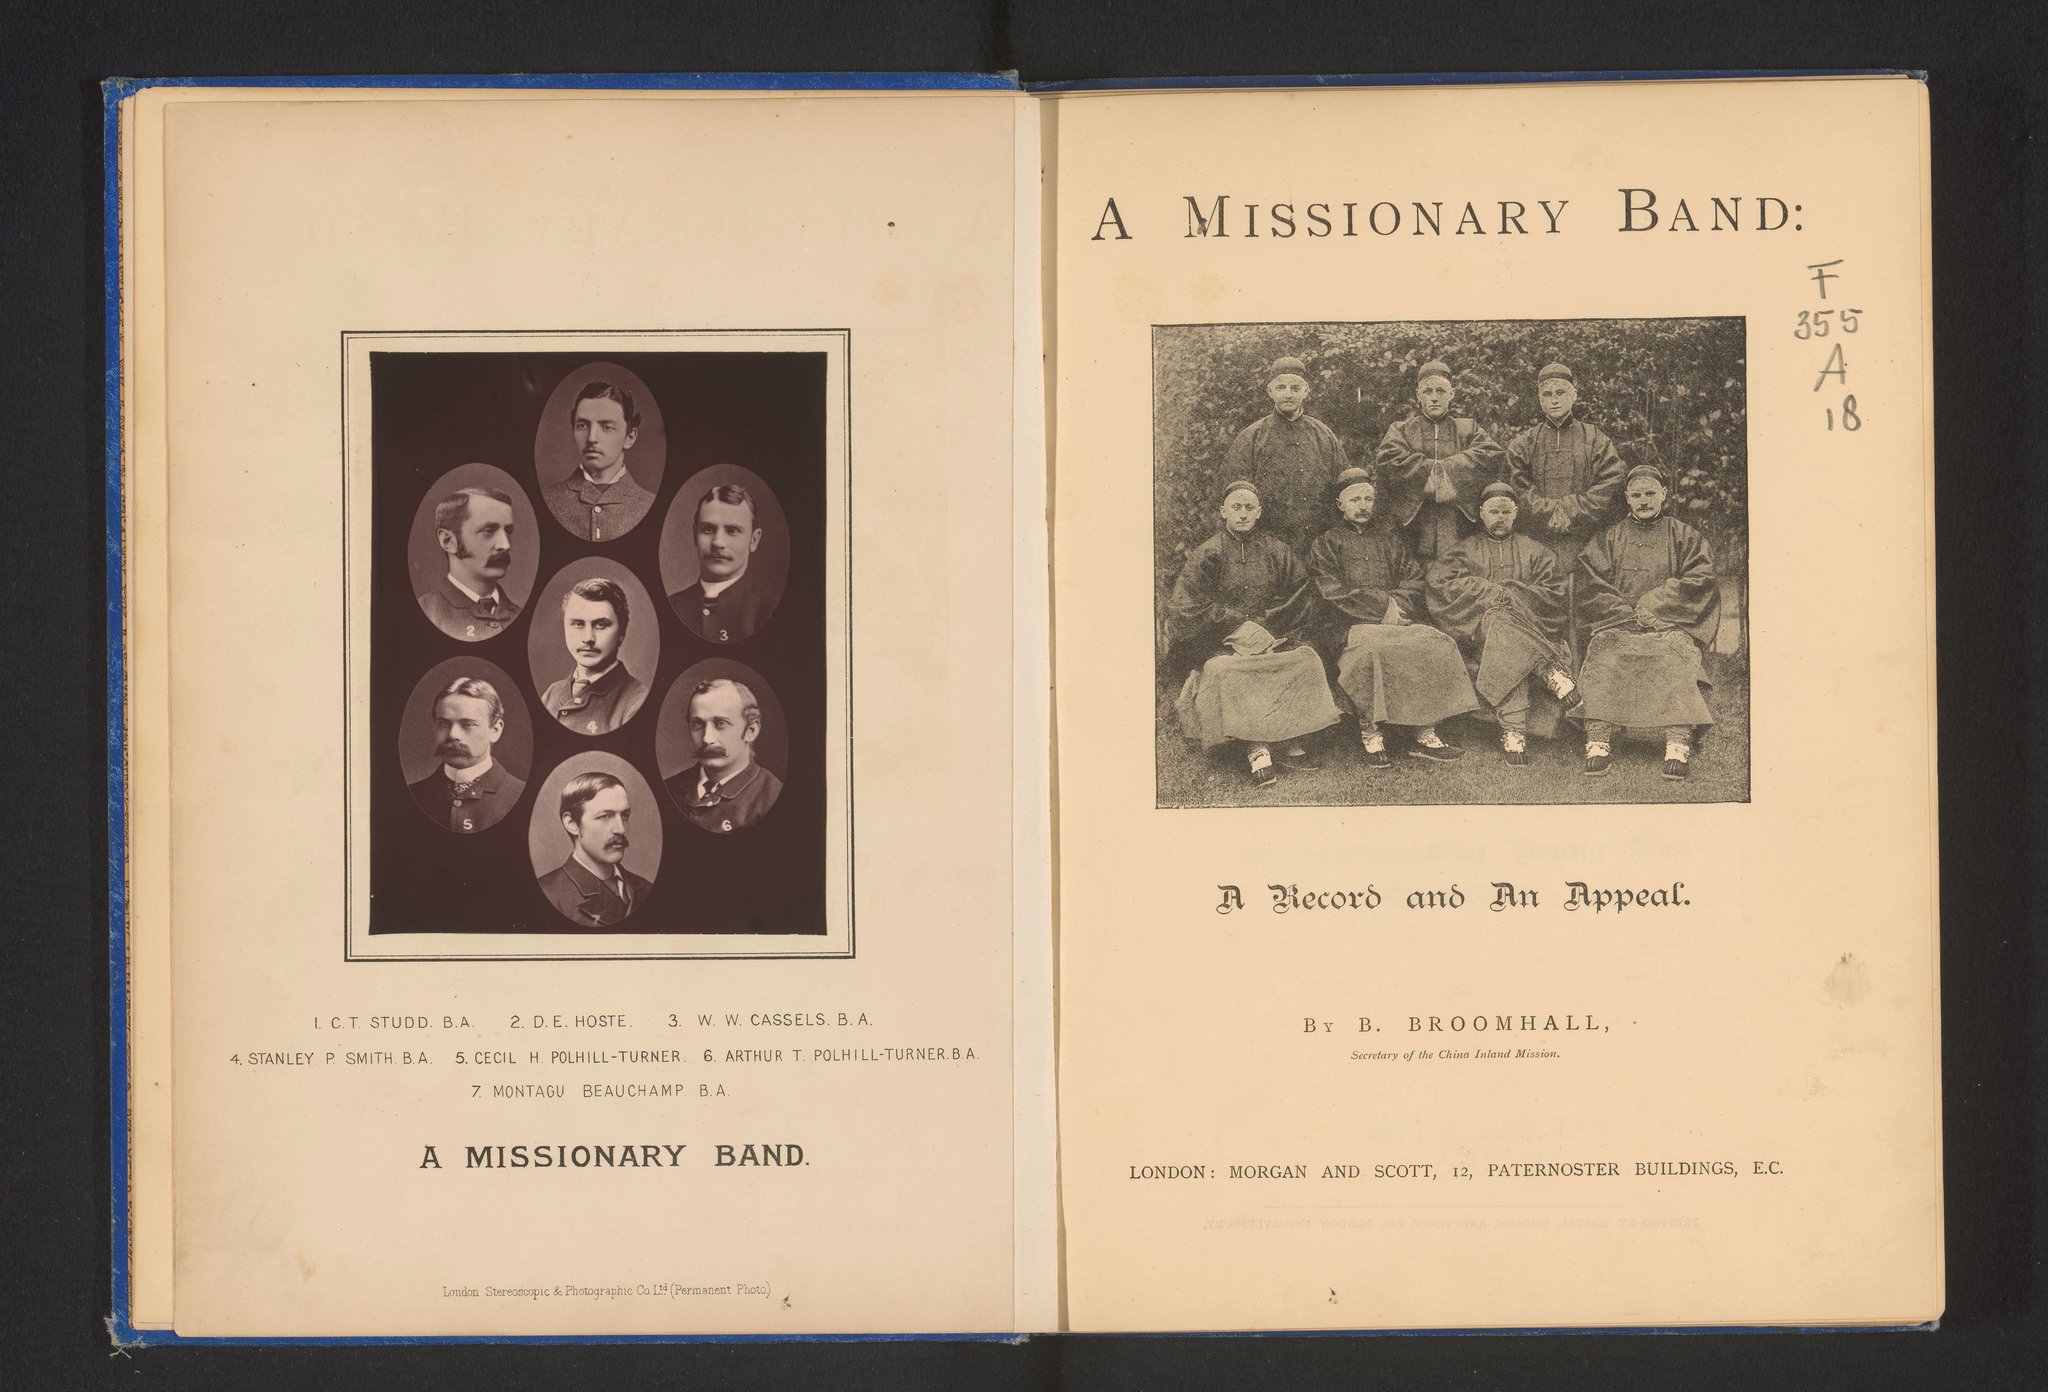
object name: page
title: Portretten van de Cambridge Seven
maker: Anonymous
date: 1881-1886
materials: paper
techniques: woodburytype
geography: london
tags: missionary, historical persons (+ head (and shoulders) (portrait)), spreading the gospel; missionary work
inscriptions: inscription: ‘1. (...) Beauchamp B.A.’